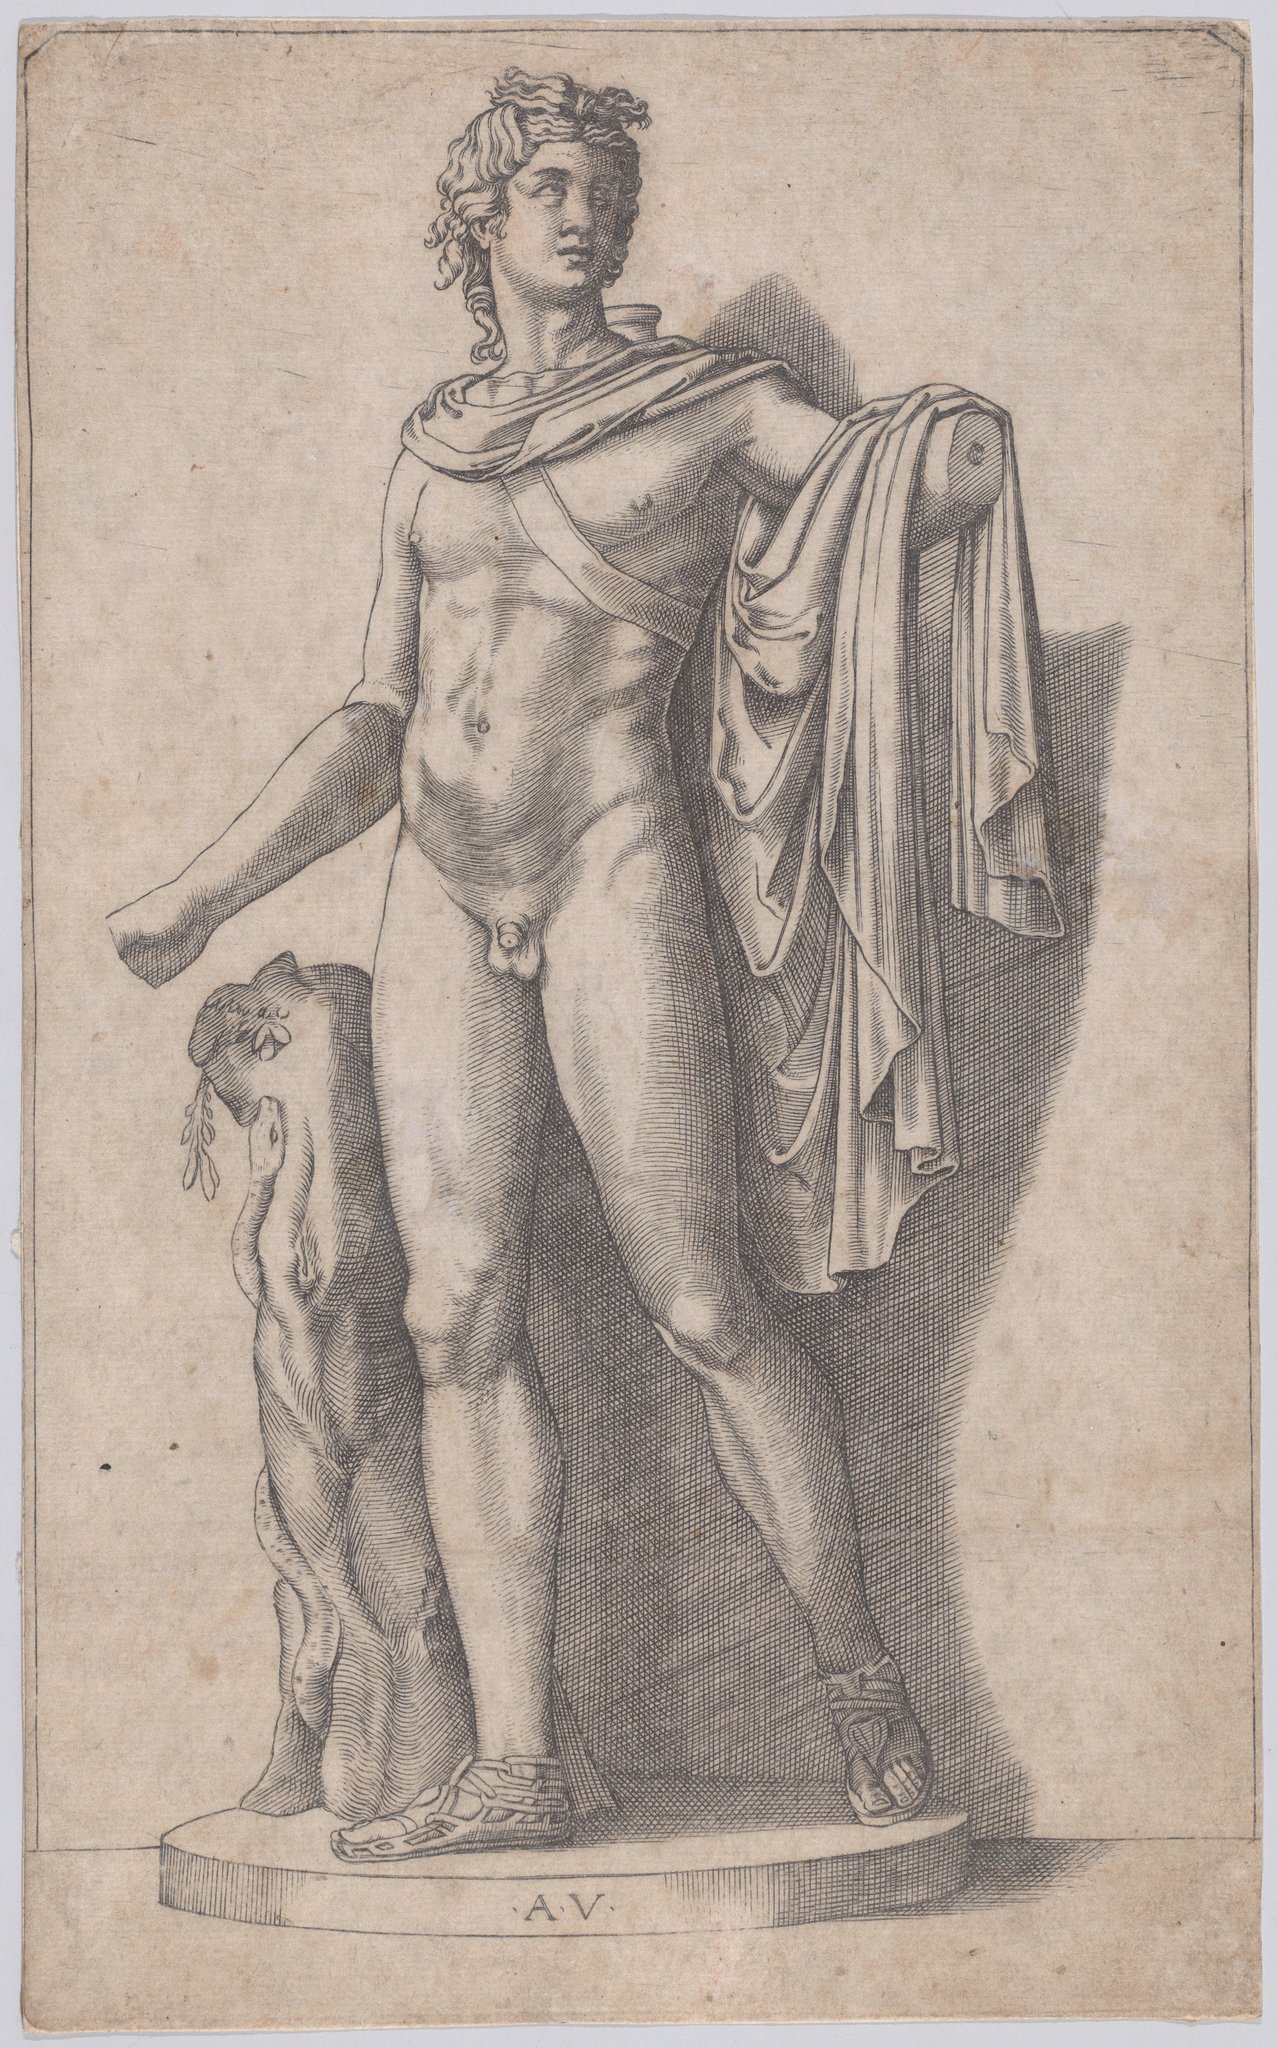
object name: print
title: Apollo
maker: agostino veneziano (agostino dei musi)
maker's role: artist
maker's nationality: italian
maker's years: 1490-1536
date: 1514-1536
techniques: engraving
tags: male nudes,apollo